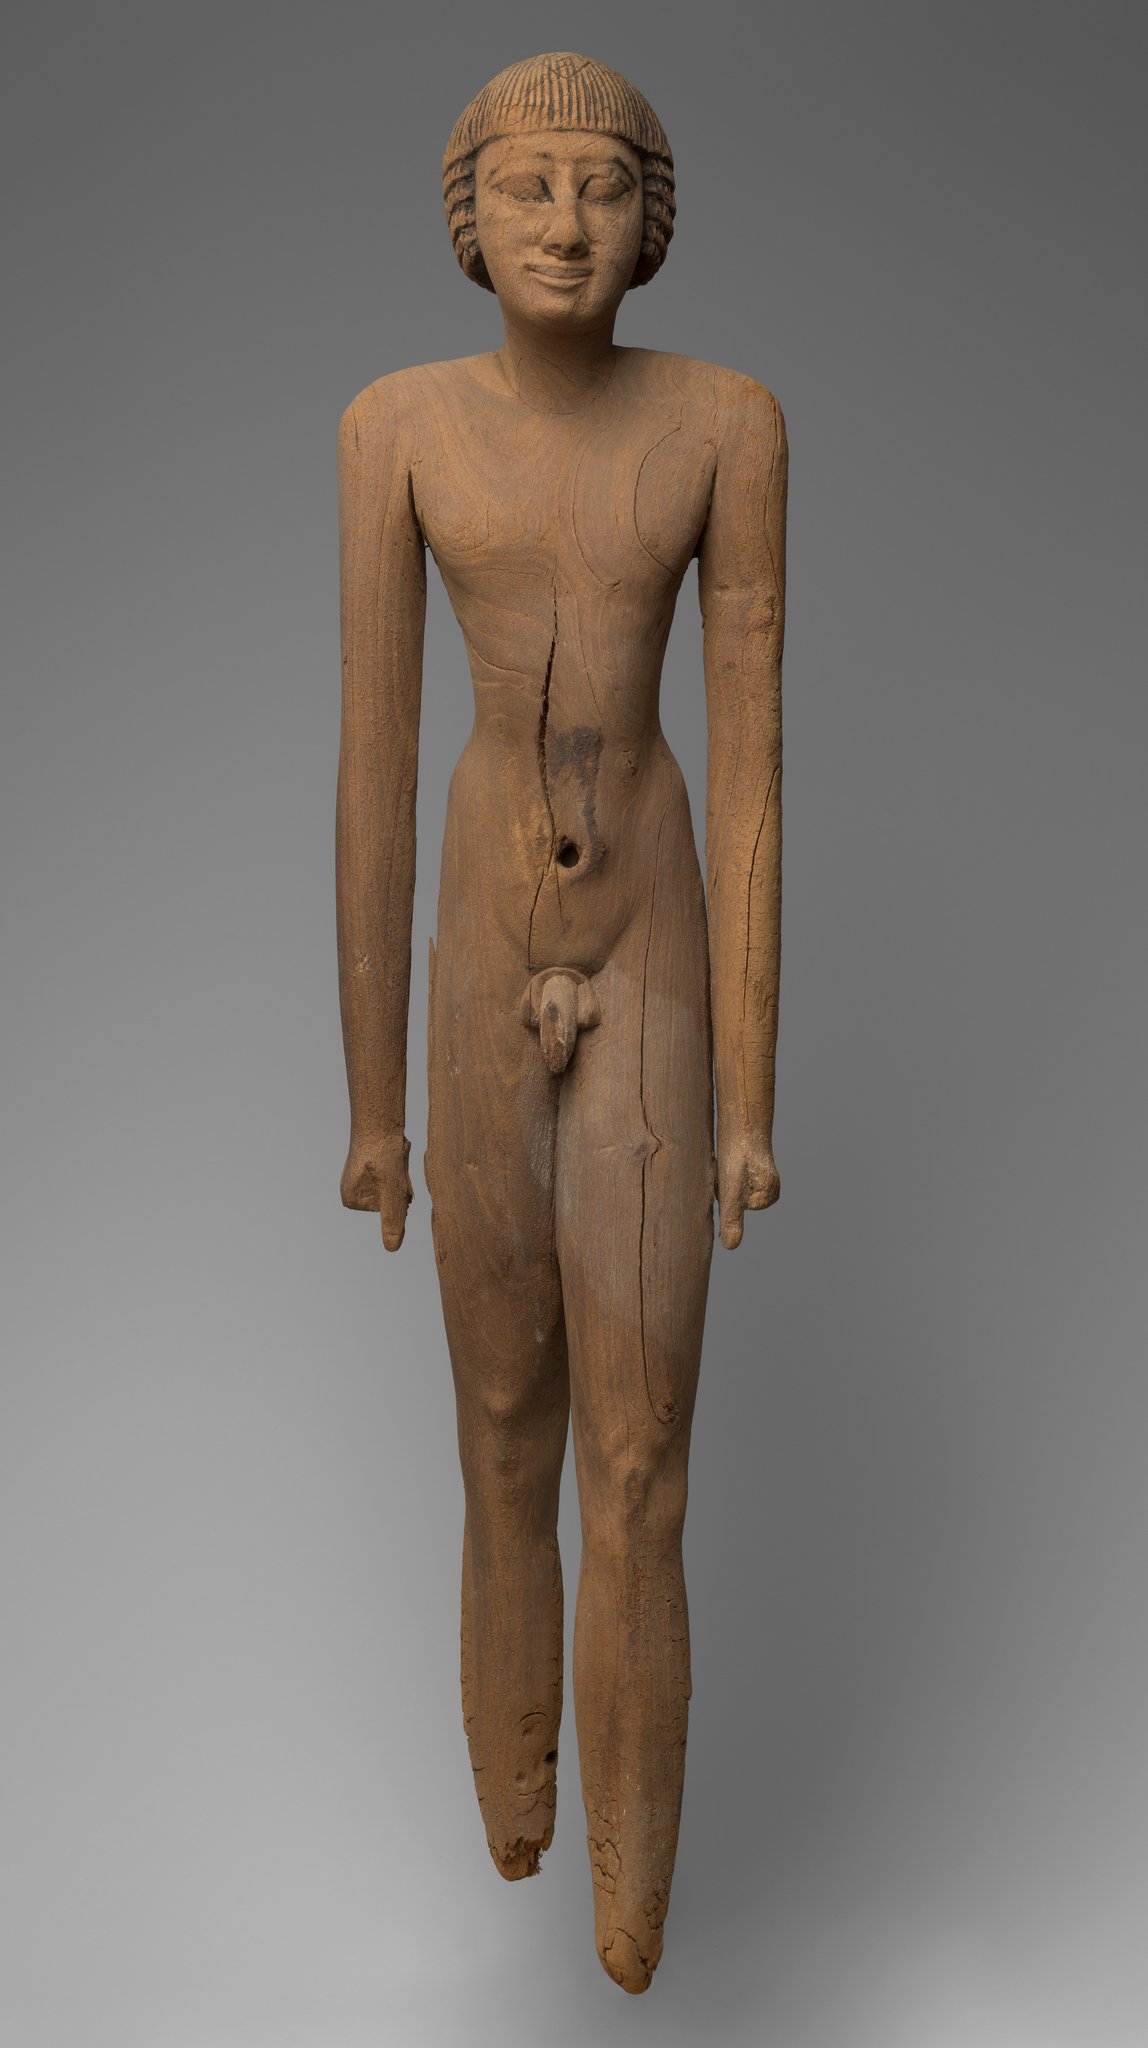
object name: statuette, striding man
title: Striding Man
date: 2255-2152 BCE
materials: wood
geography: egypt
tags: male nudes